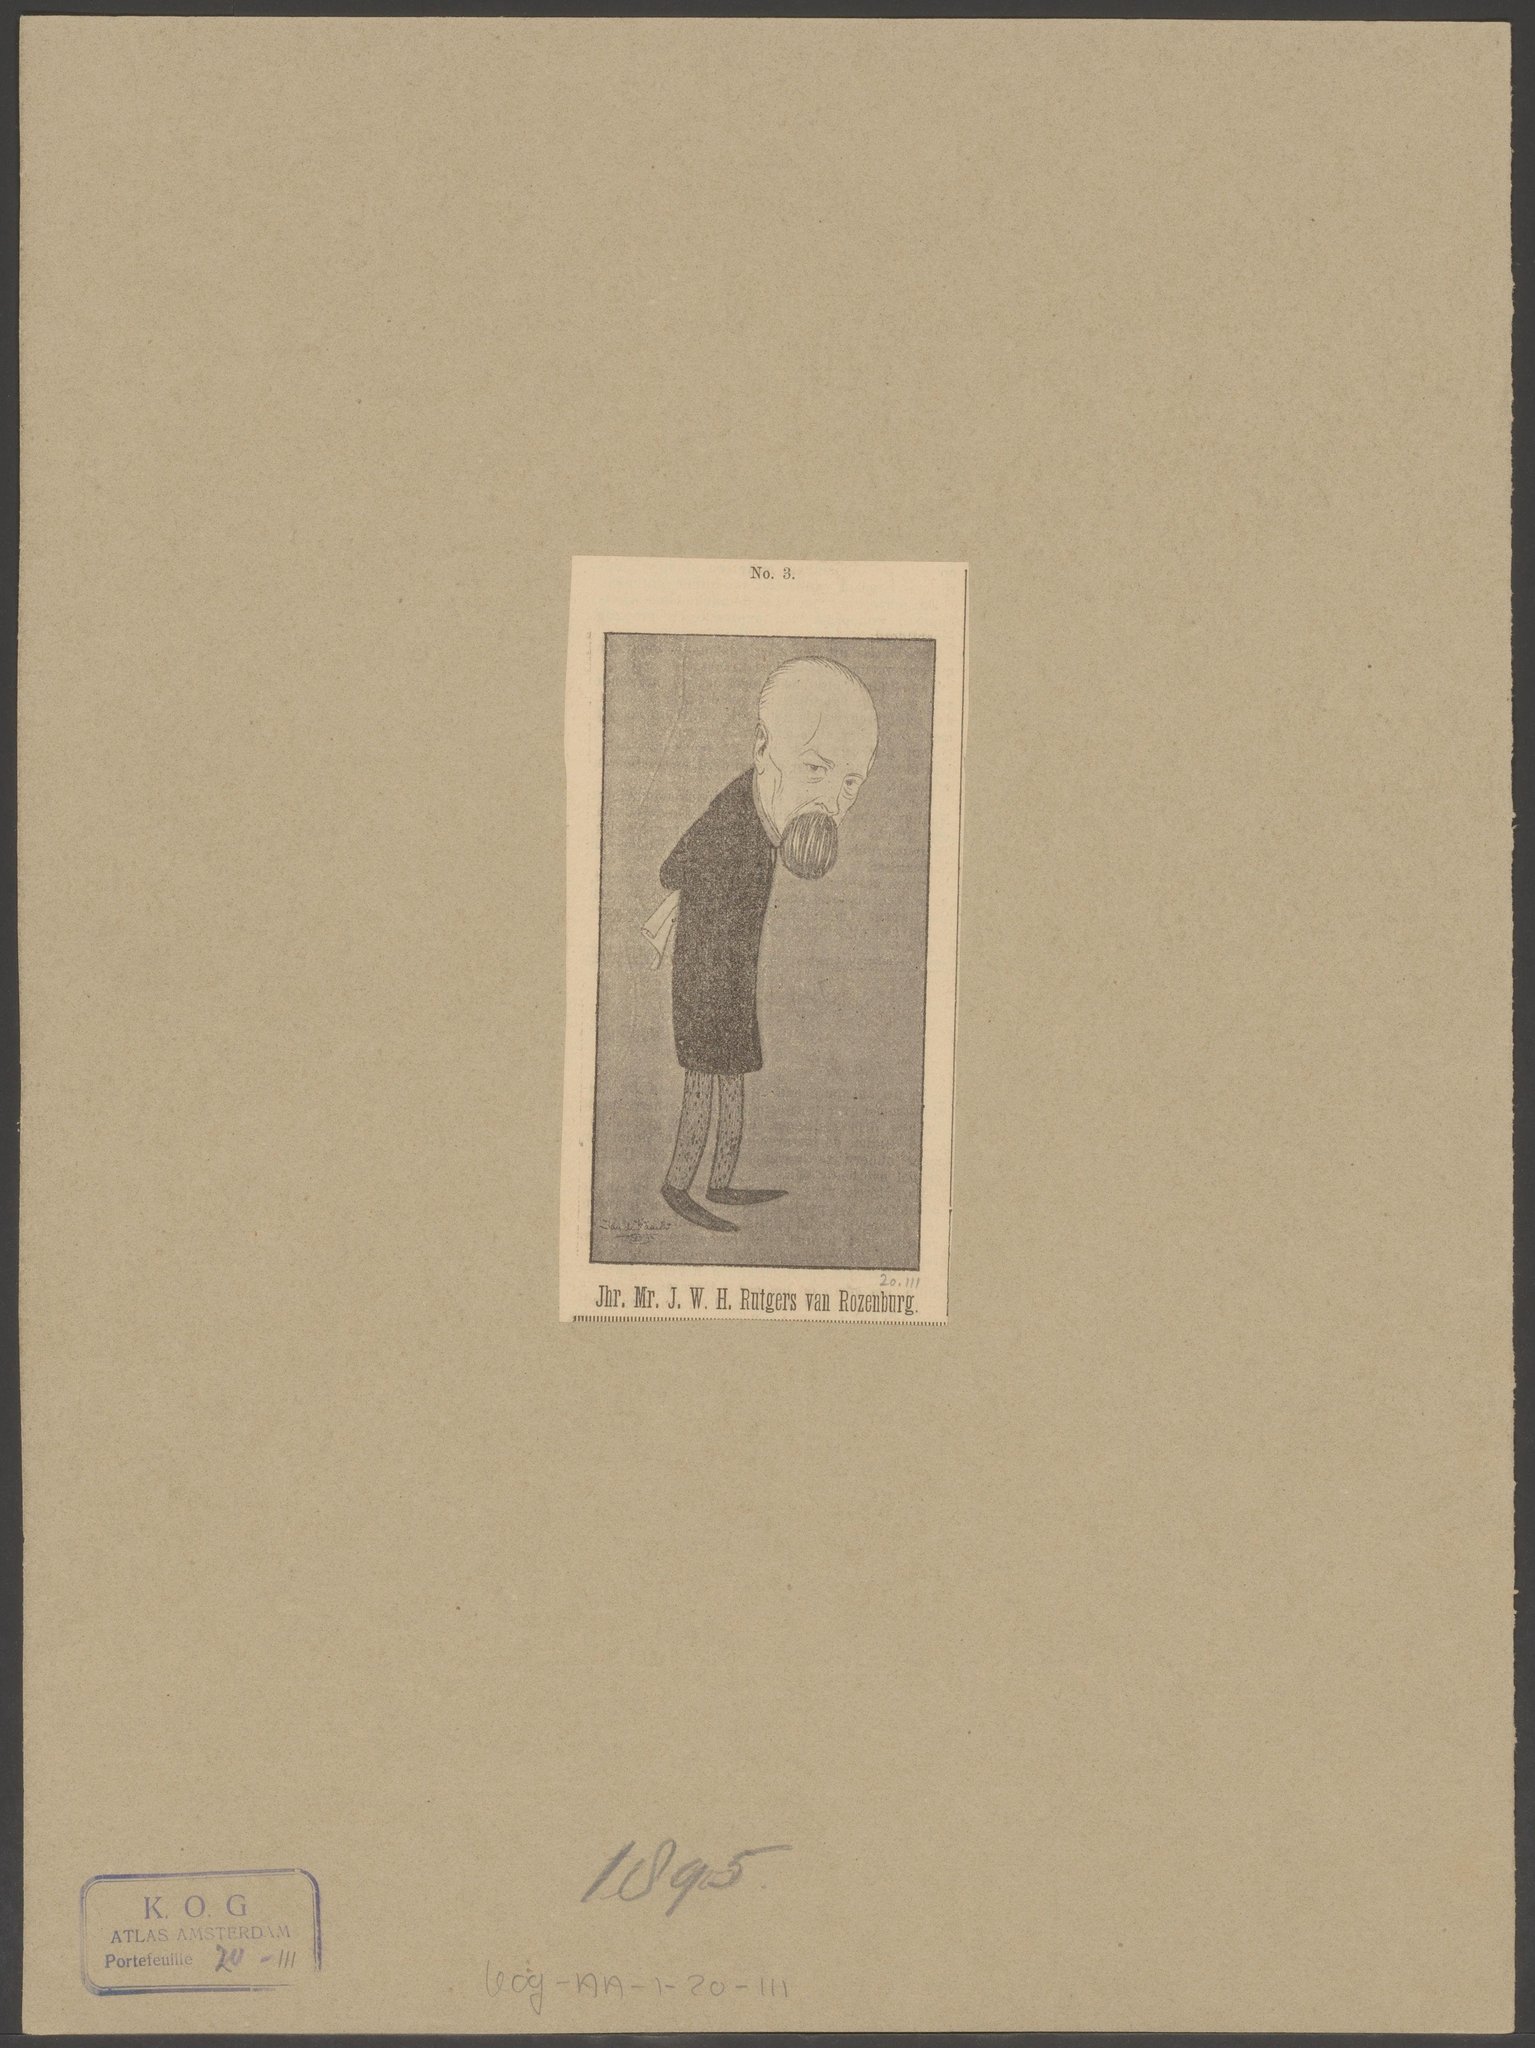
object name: cartoon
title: Jhr. Mr. J.W.H. Rutgers van Rozenburg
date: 1895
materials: paper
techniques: letterpress printing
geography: netherlands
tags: politician, e.g. party leader, political caricatures and satires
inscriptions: collector's mark: Lugt 1641b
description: Midden boven genummerd: No. 3. Onderwerpsrubriek binnen de Atlas Amsterdam: Verkiezingen Gemeenteraad.